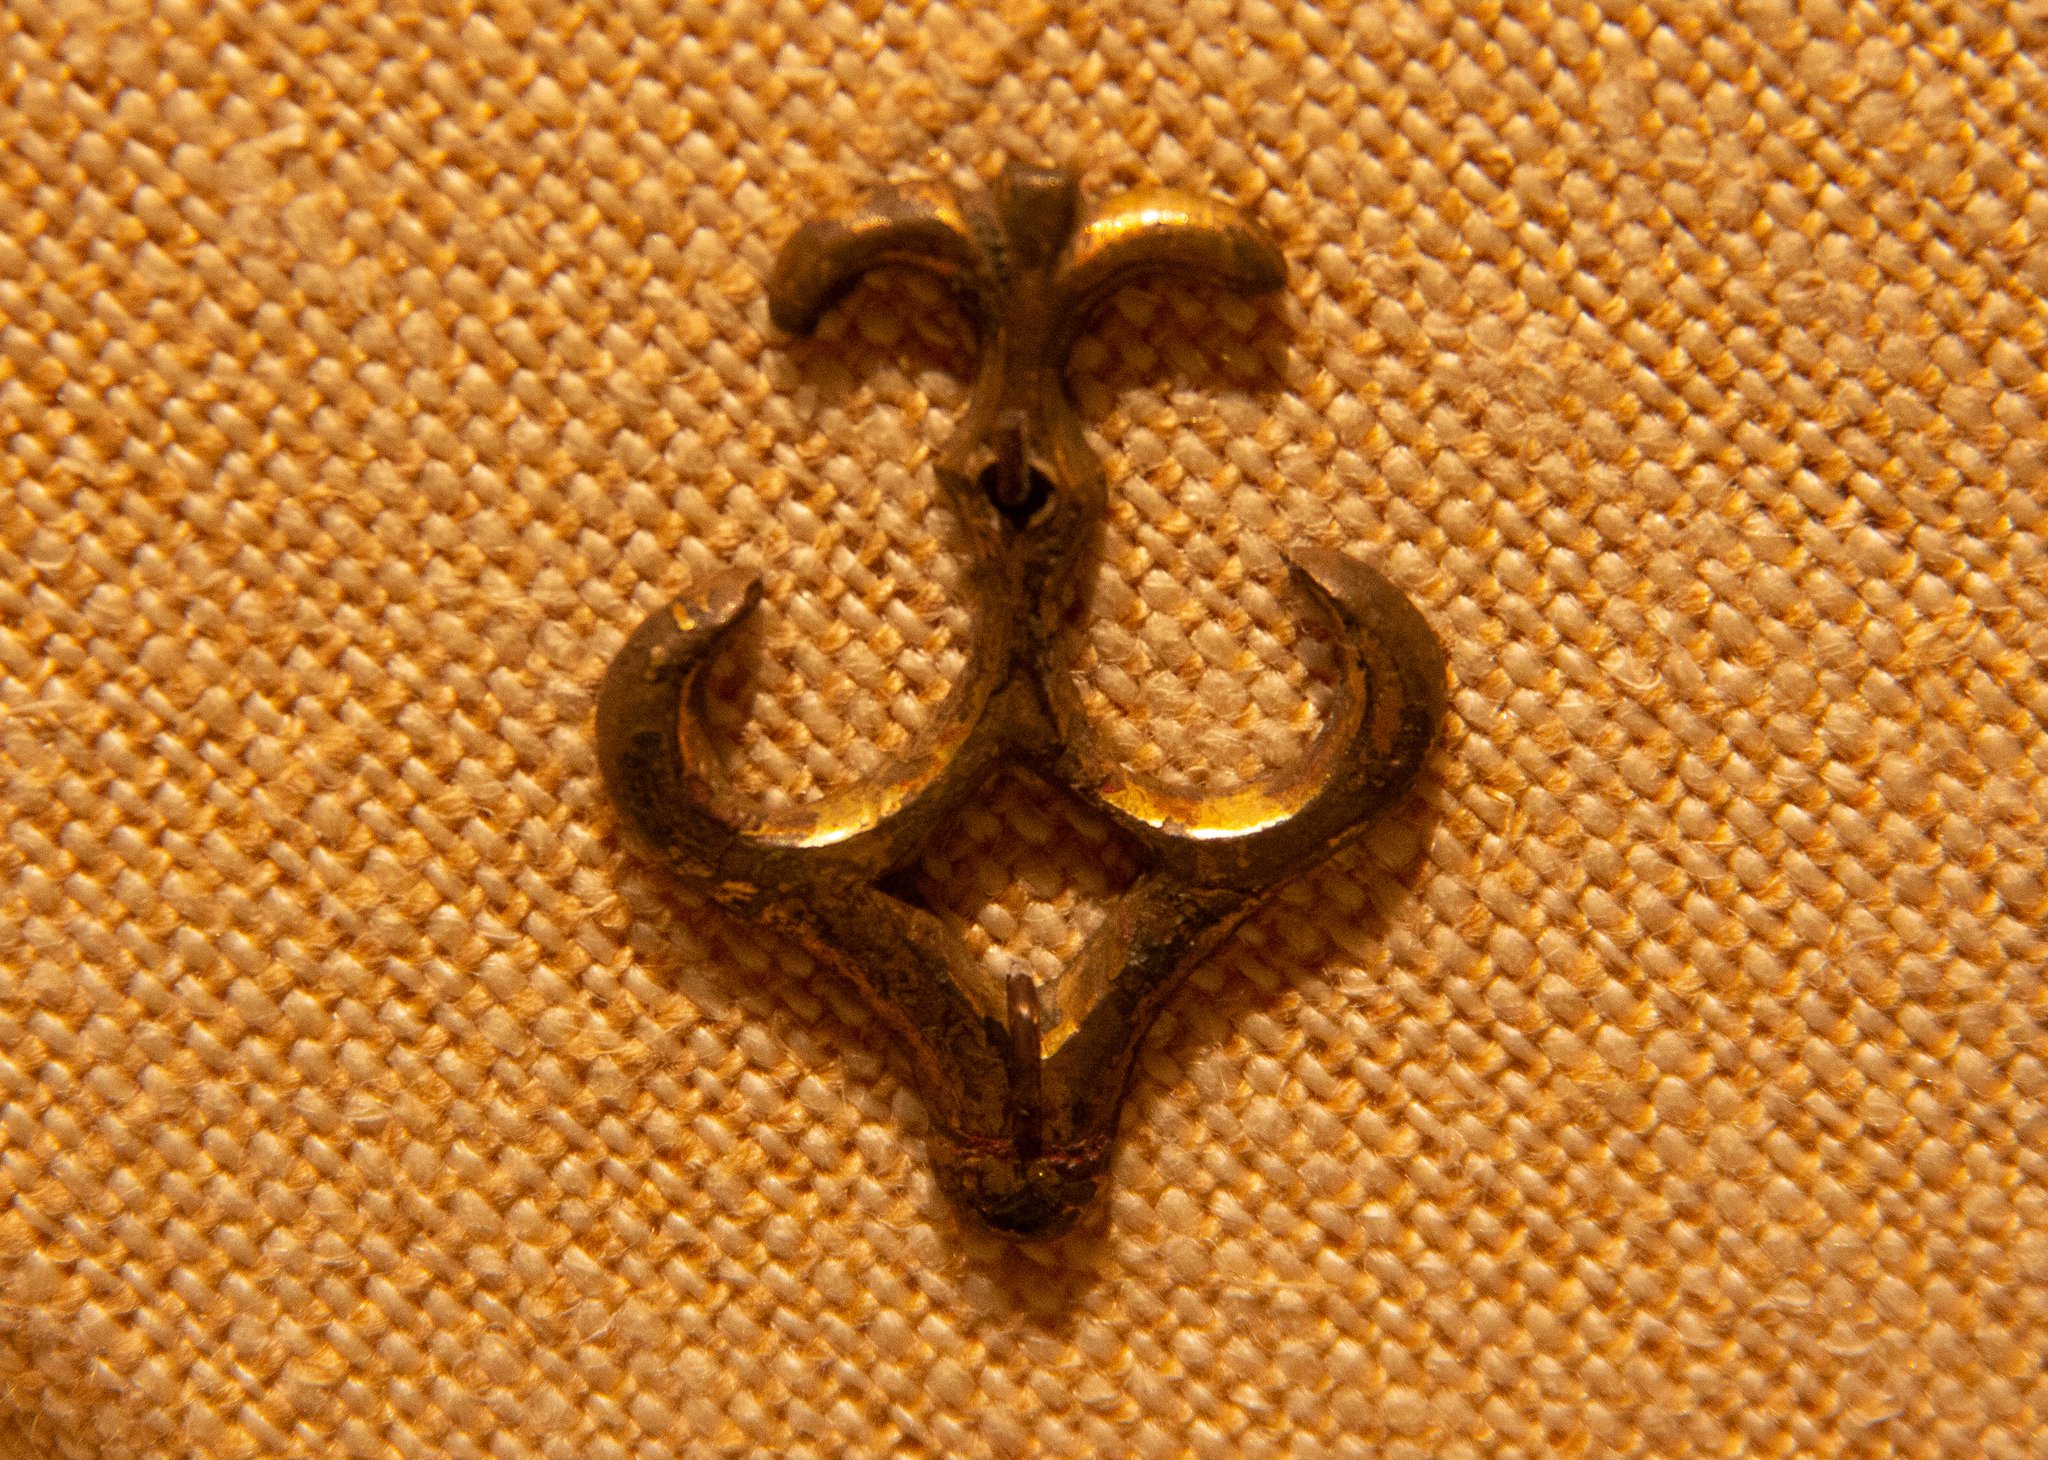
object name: horse trapping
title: Horse Harness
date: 801-1000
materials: bronze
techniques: casting, gilding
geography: iran